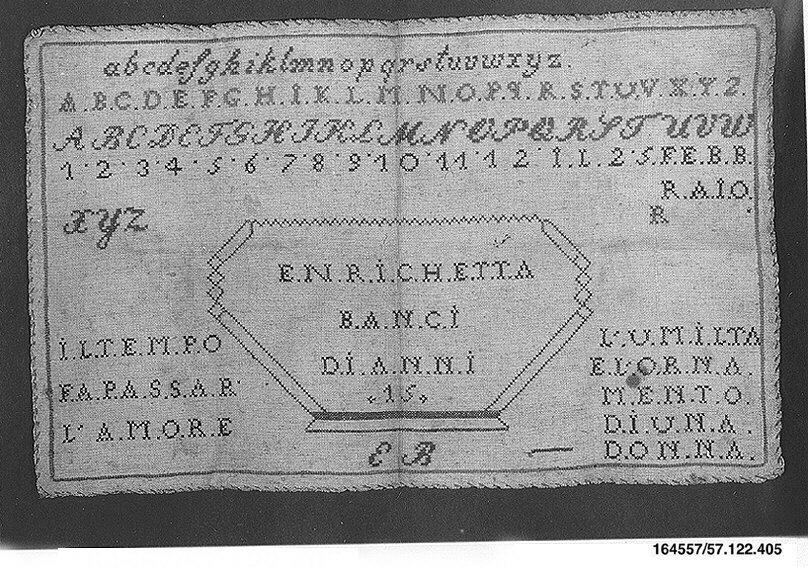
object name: sampler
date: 1815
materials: linen, silk